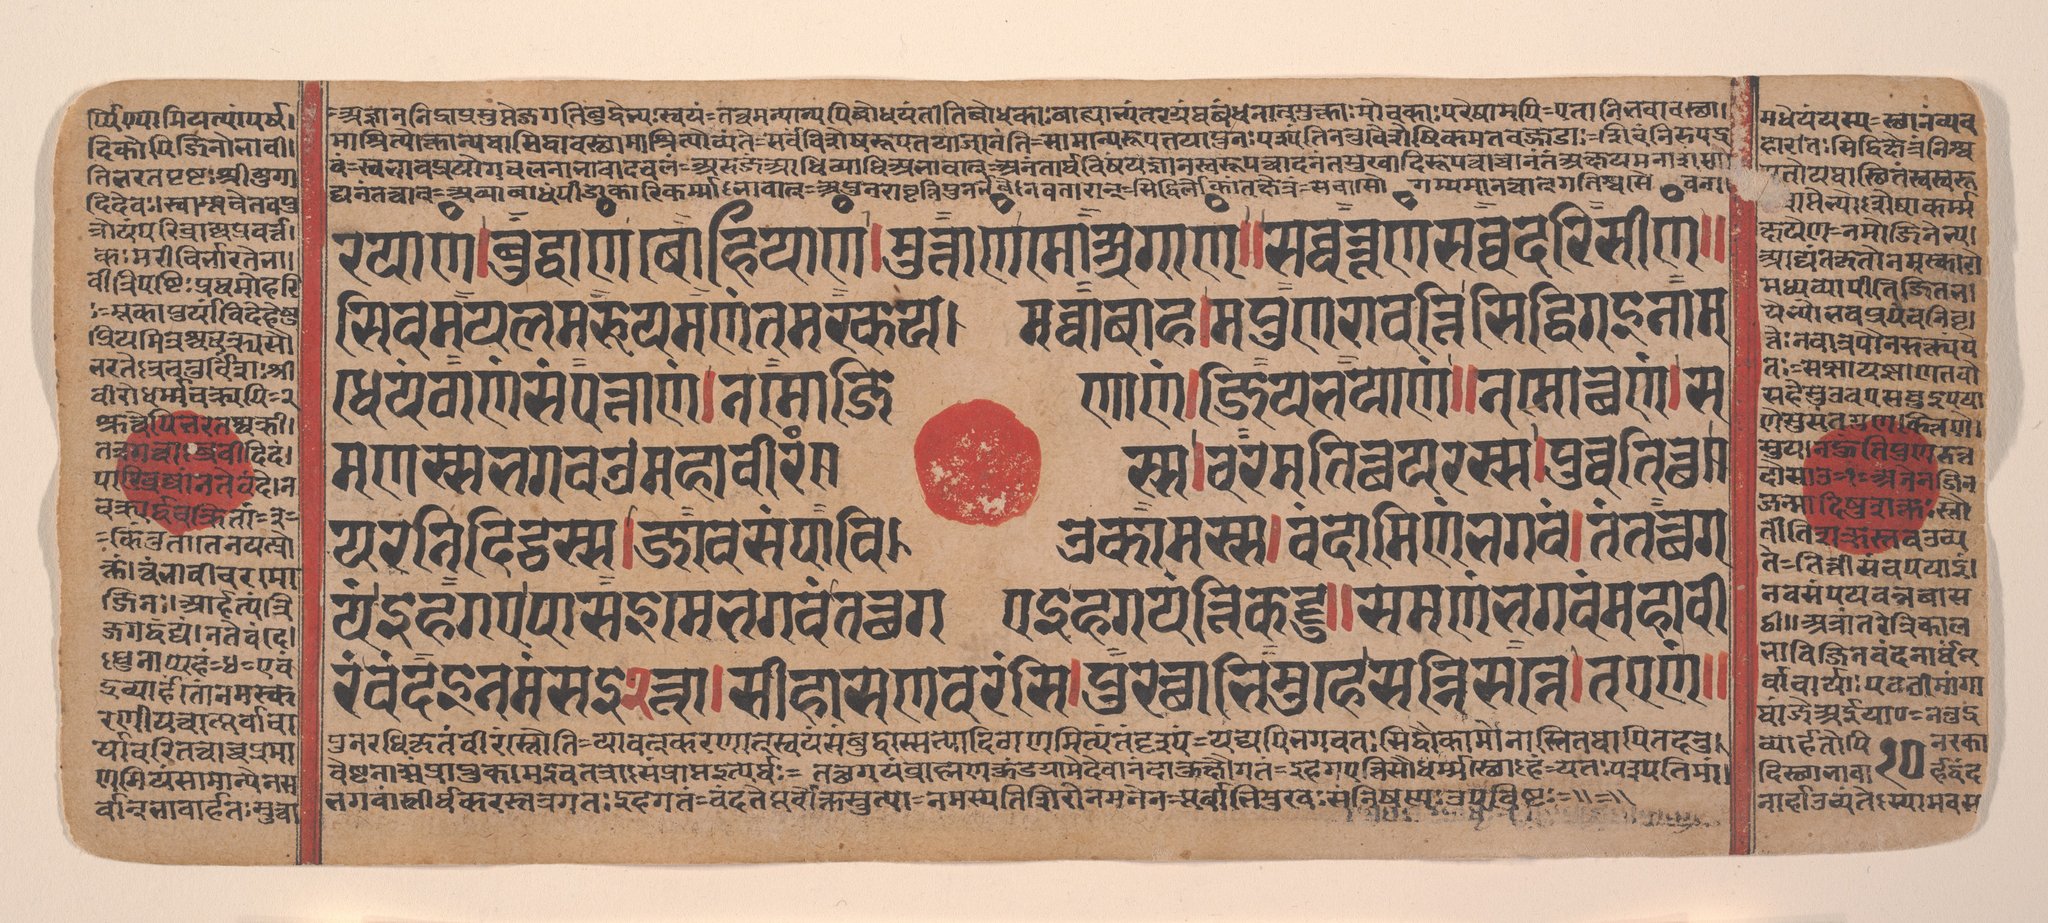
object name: folio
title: Page from a Dispersed Kalpa Sutra (Jain Book of Rituals)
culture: indian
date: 1401-1500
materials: gold, ink, paper, watercolor